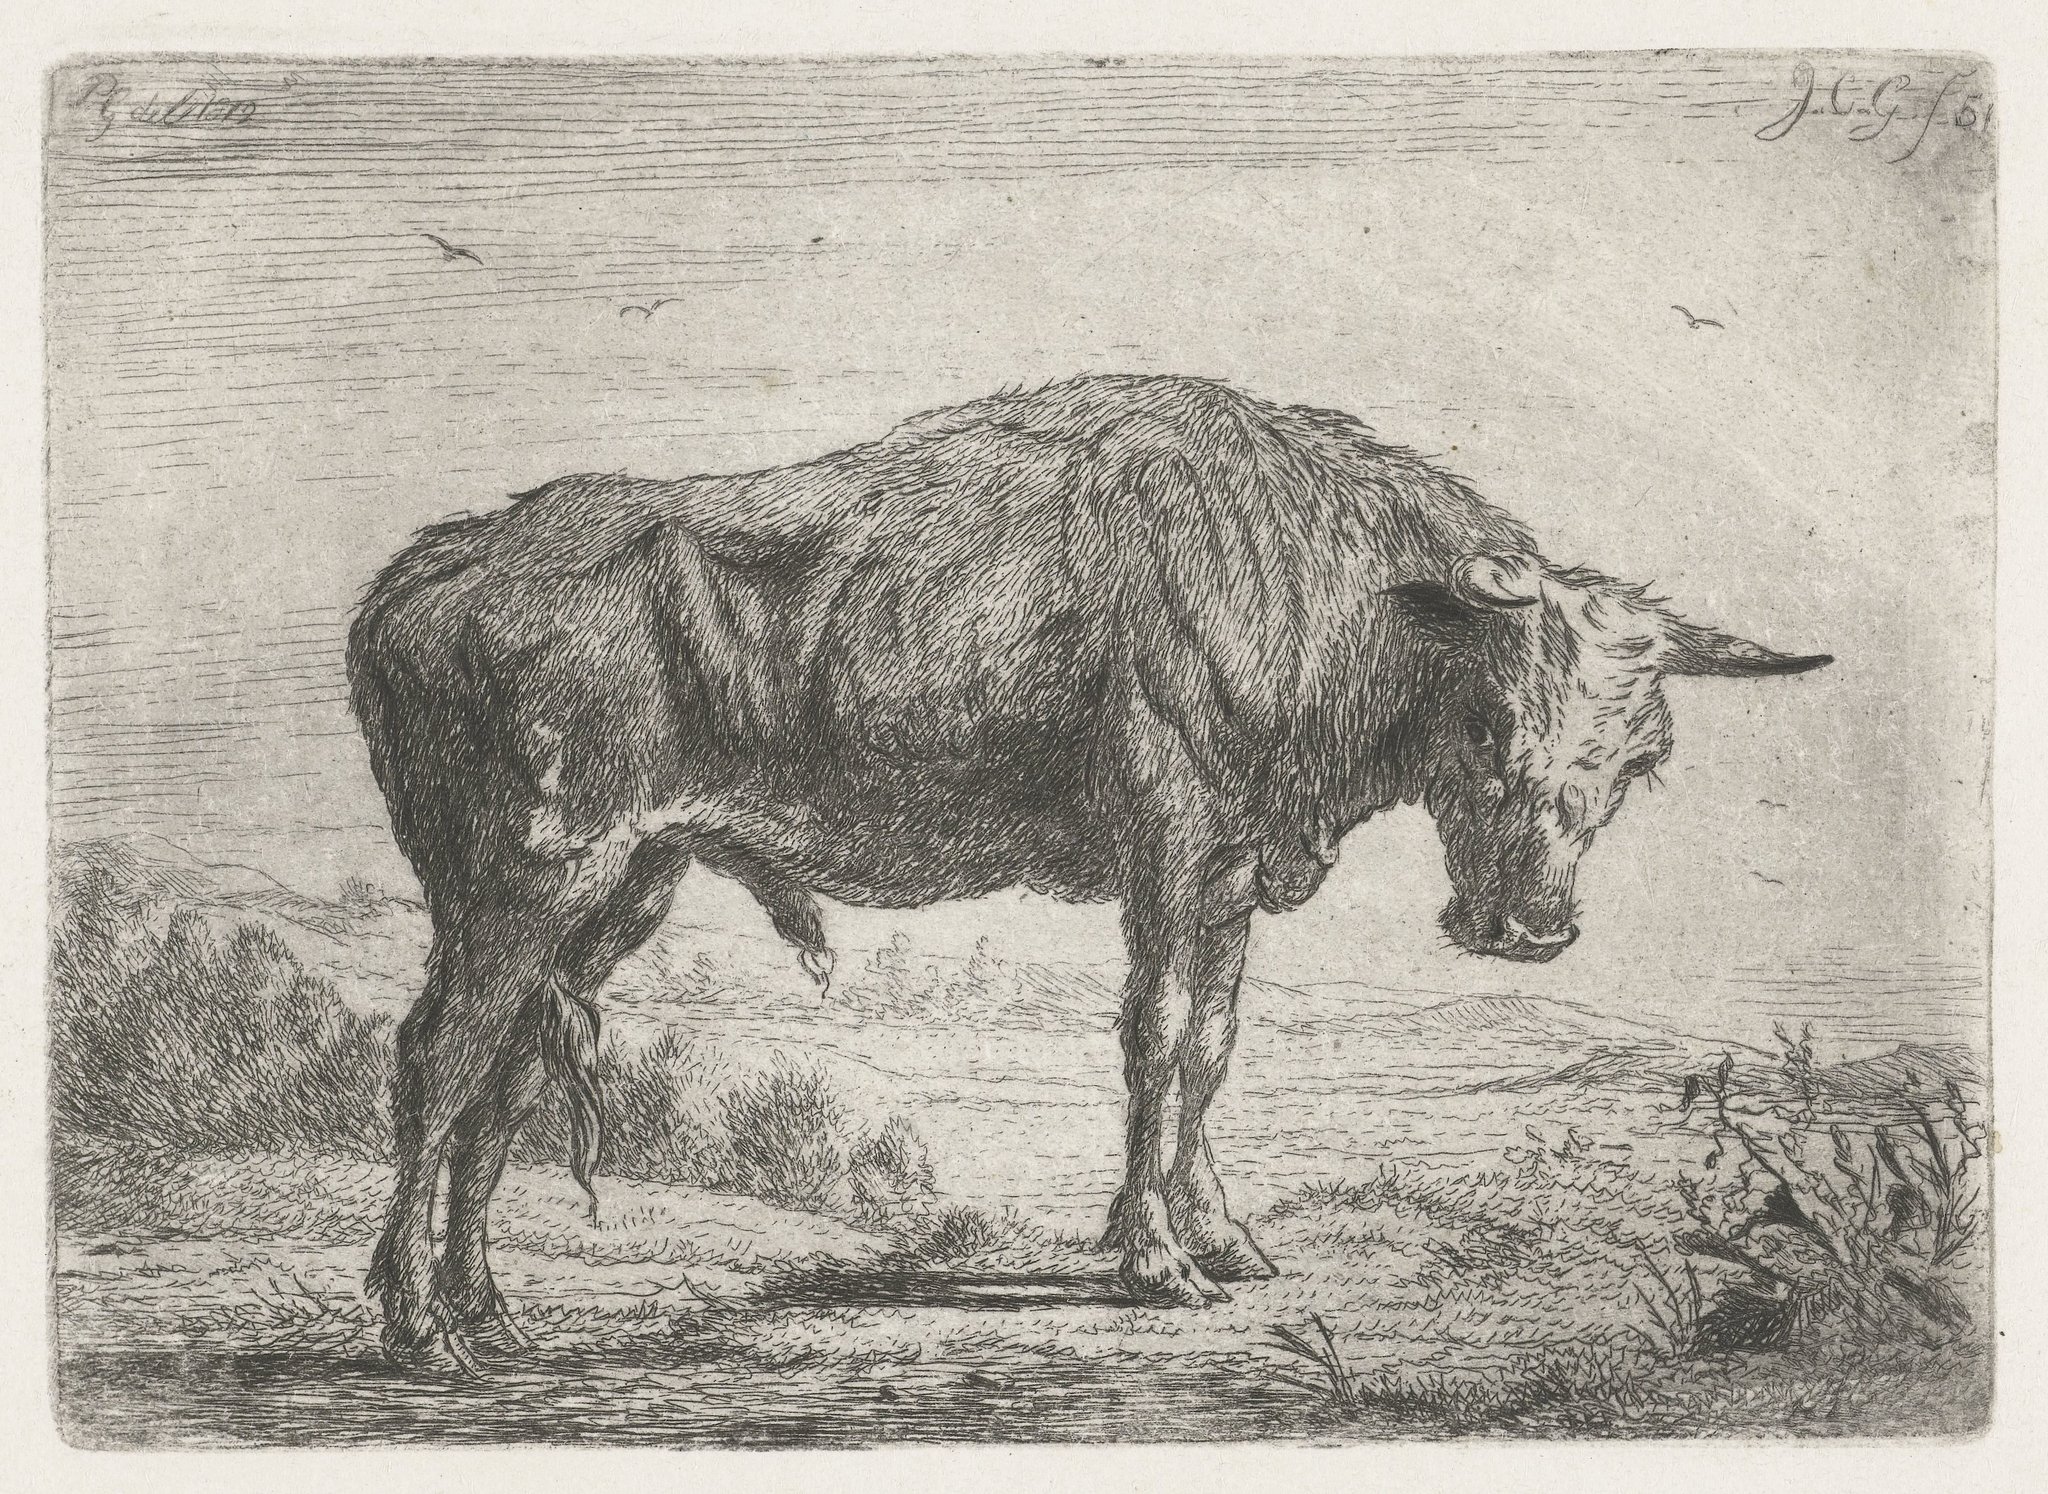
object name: print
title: Staande stier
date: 1851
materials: paper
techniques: etching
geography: netherlands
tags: bull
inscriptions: collector's mark: Lugt 2228, collector's mark: Lugt 2760